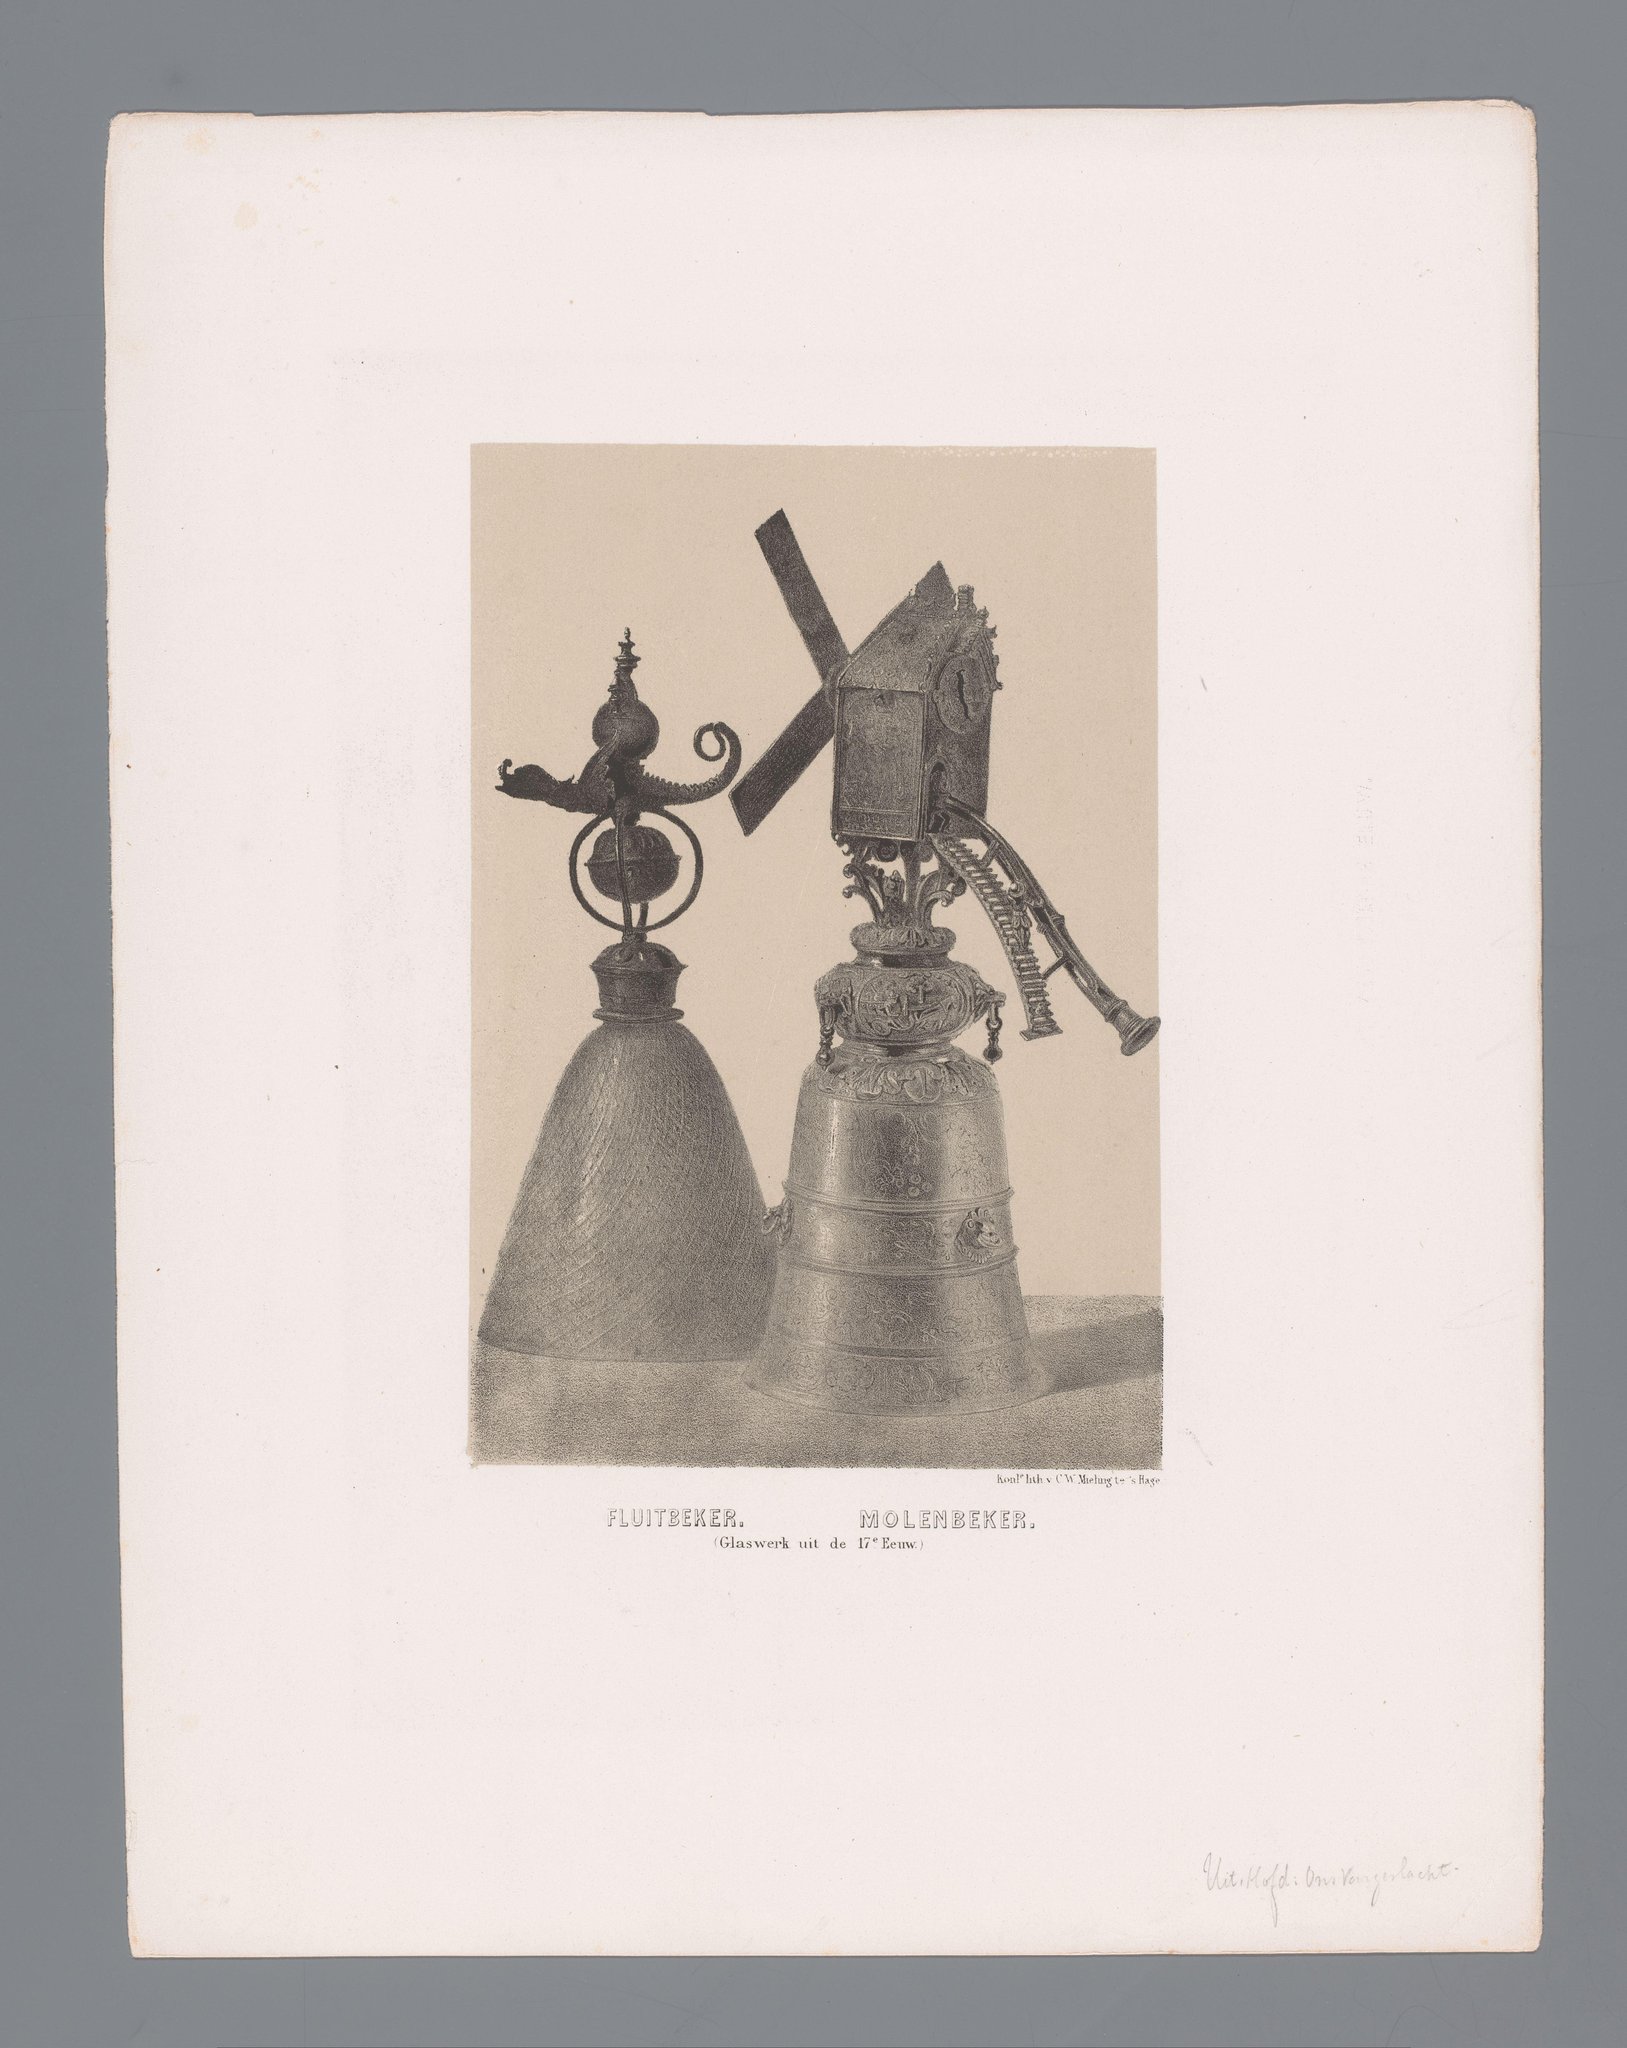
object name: print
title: Fluitbeker molenbeker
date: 1864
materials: paper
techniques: tone lithography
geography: the hague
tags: cup, windmill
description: De bekers staan met de kelk naar beneden. In plaats van een voet hebben de bekers een vogelachtig wezen en een molen.